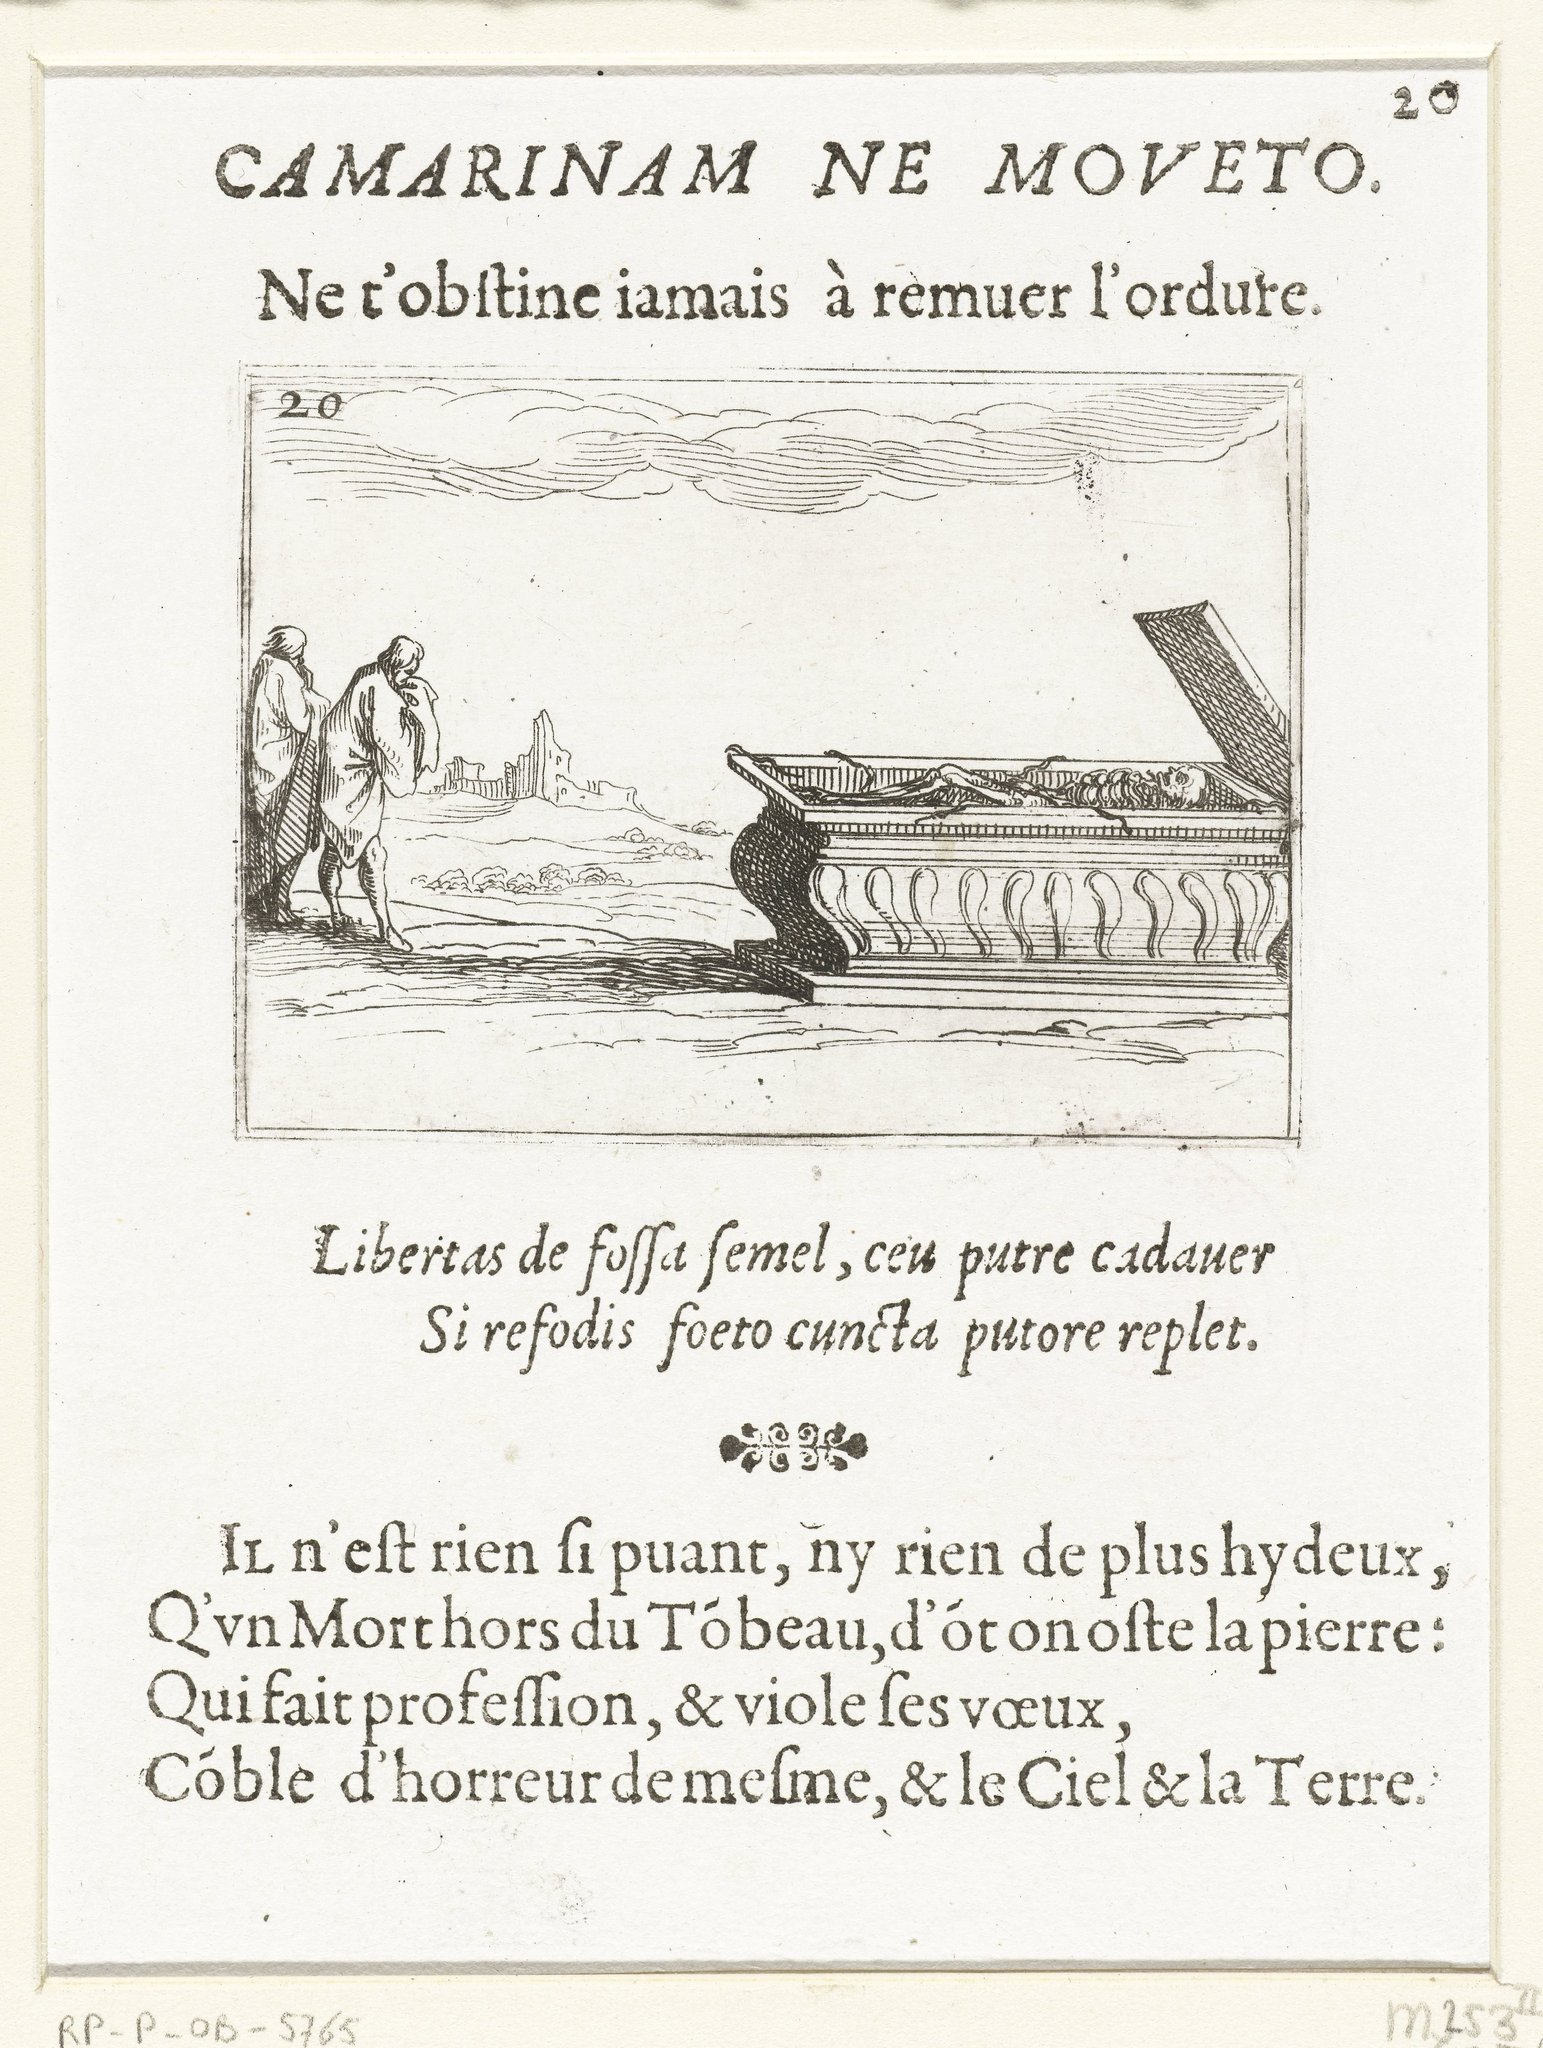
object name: print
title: Kloosterleven in emblemen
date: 1621-1635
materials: paper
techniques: etching, letterpress printing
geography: nancy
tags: grave, tomb, sarcophagus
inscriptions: collector's mark: Lugt 240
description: Voorstelling van een skelet in een geopende sarcofaag; twee mannen staan ernaast. Boven en onder deze prent Latijnse en Franse teksten in boekdruk. Dit blad is onderdeel van de embleemserie 'Kloosterleven in emblemen'. De tweede staat van deze serie behelst naast een geïllustreerde titelpagina en 26 emblemen nog een titelpagina en een blad met opdracht, beide in boekdruk zonder afbeelding.